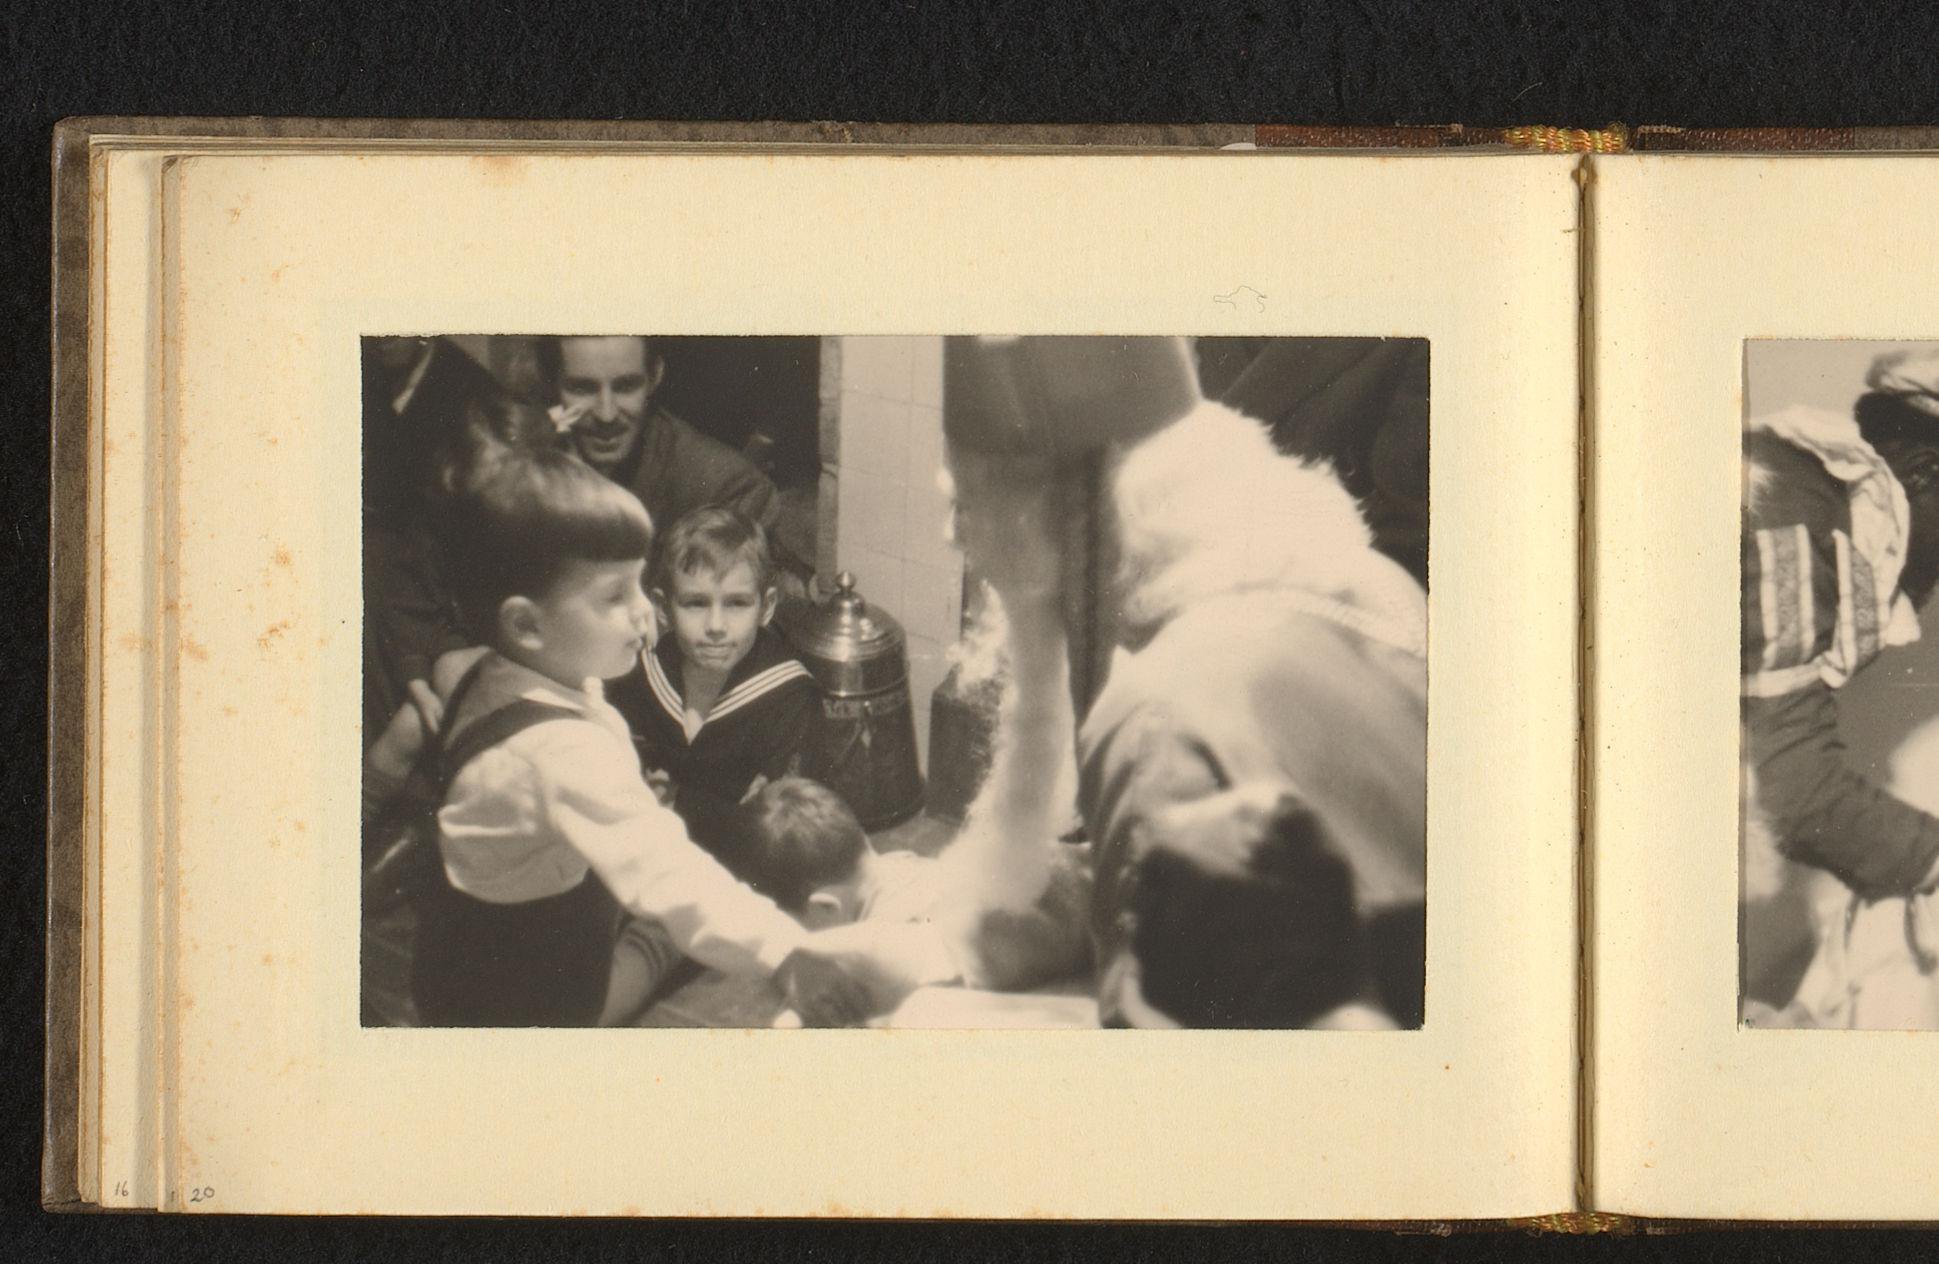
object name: photograph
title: Kinderen met Sinterklaas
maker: norbert van den berg (1901-1972)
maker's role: amateurfotograaf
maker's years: 1901-1972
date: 1935-1950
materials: paper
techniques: gelatin silver print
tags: child, festivities on st. nicholas (eve) (december 5), saint nicholas day